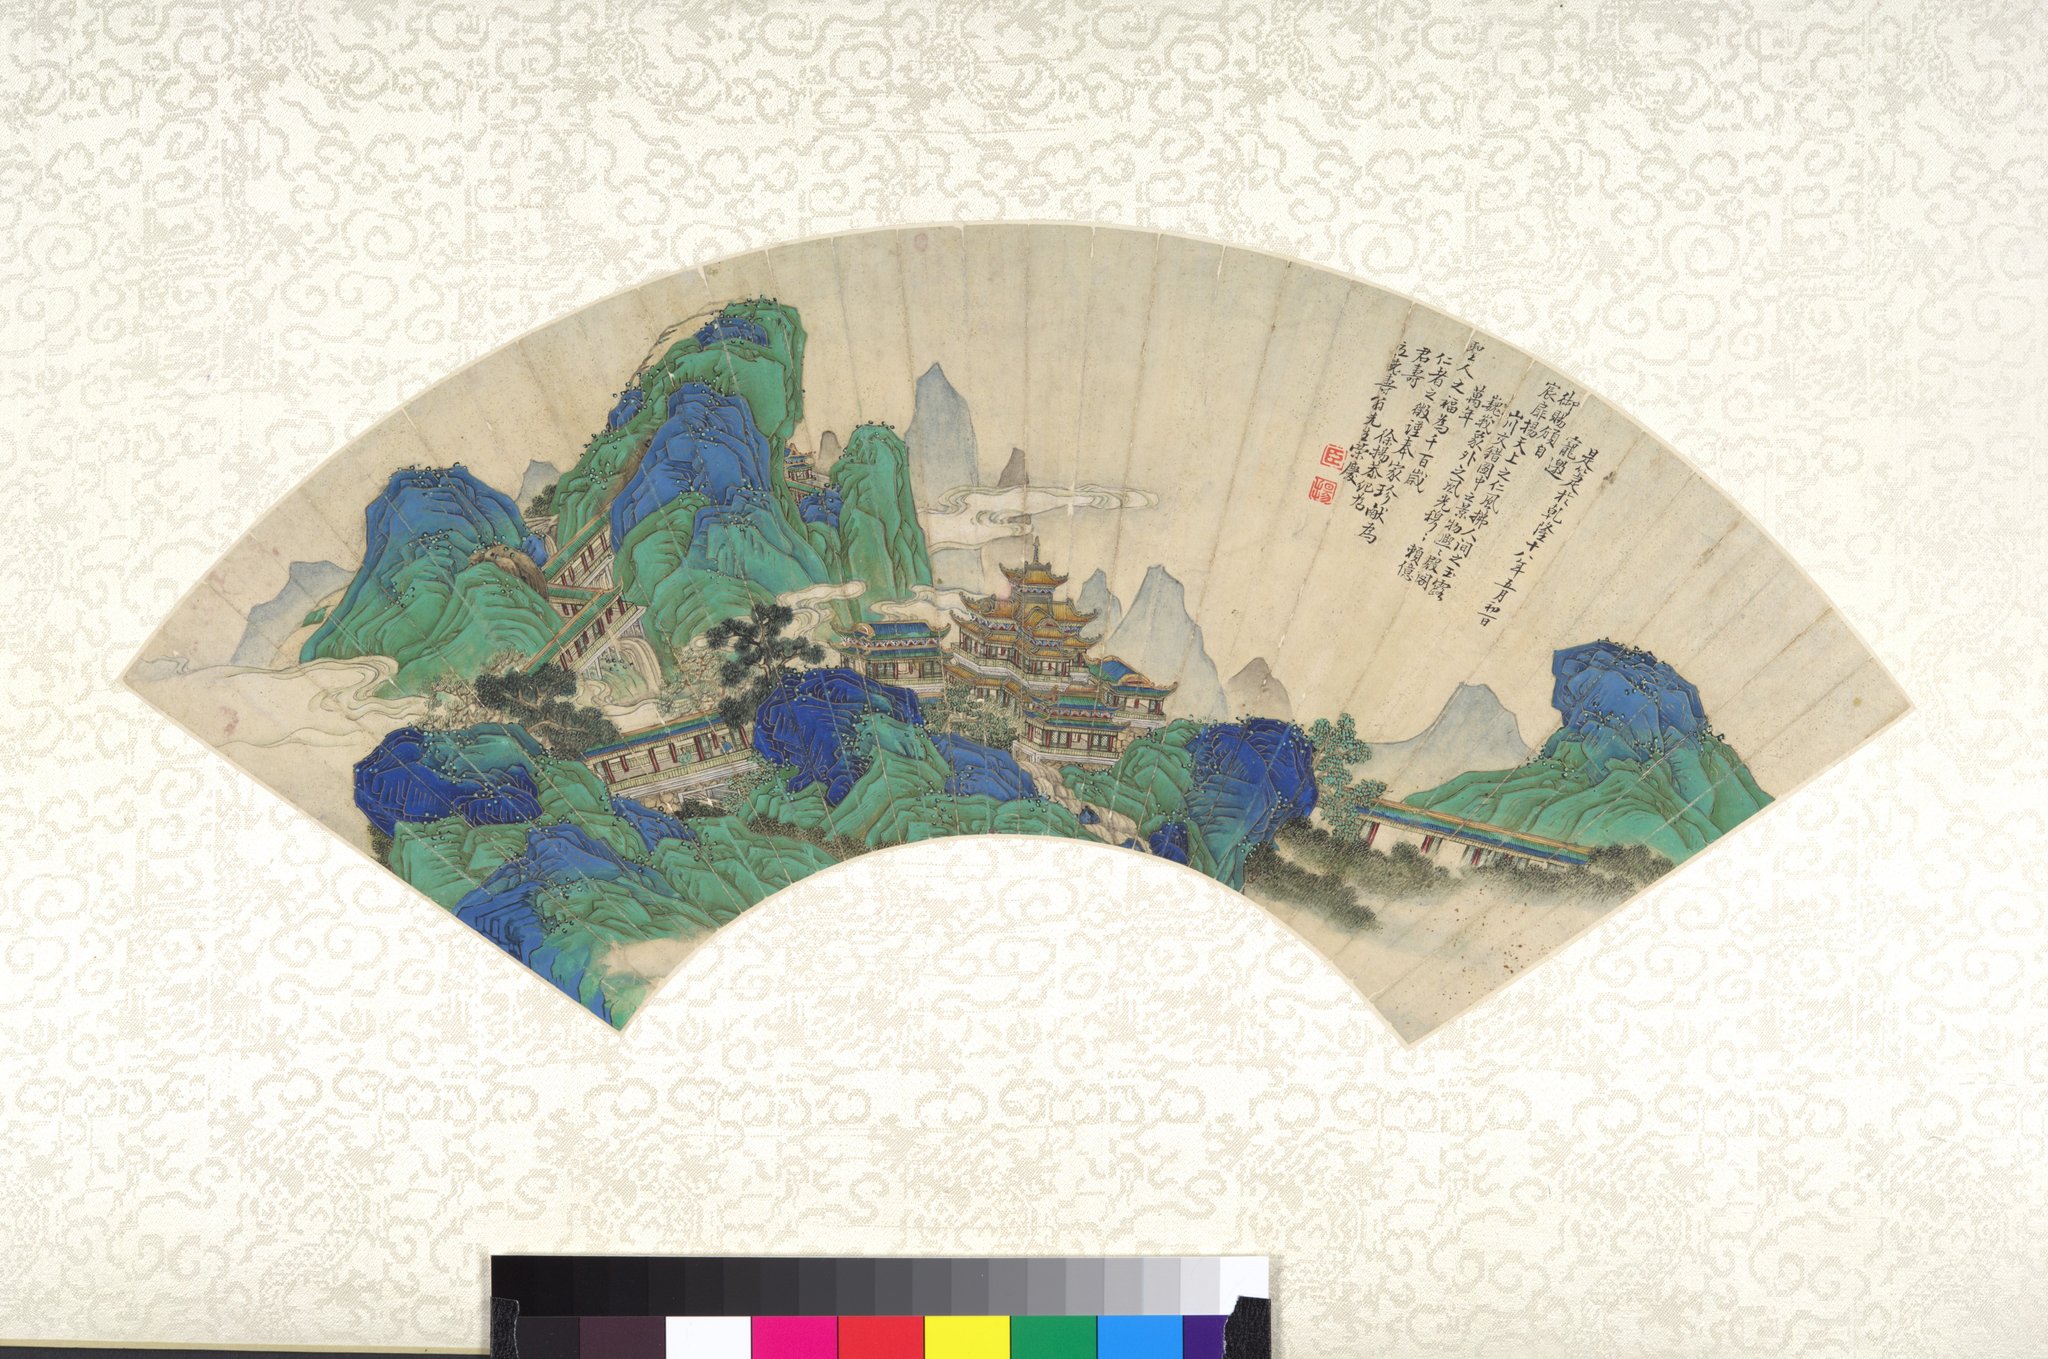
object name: folding fan mounted a an album leaf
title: Palaces of the Immortals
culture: chinese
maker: xu yang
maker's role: artist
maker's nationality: chinese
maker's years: 1750-1776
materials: gold, ink, paper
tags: mountains